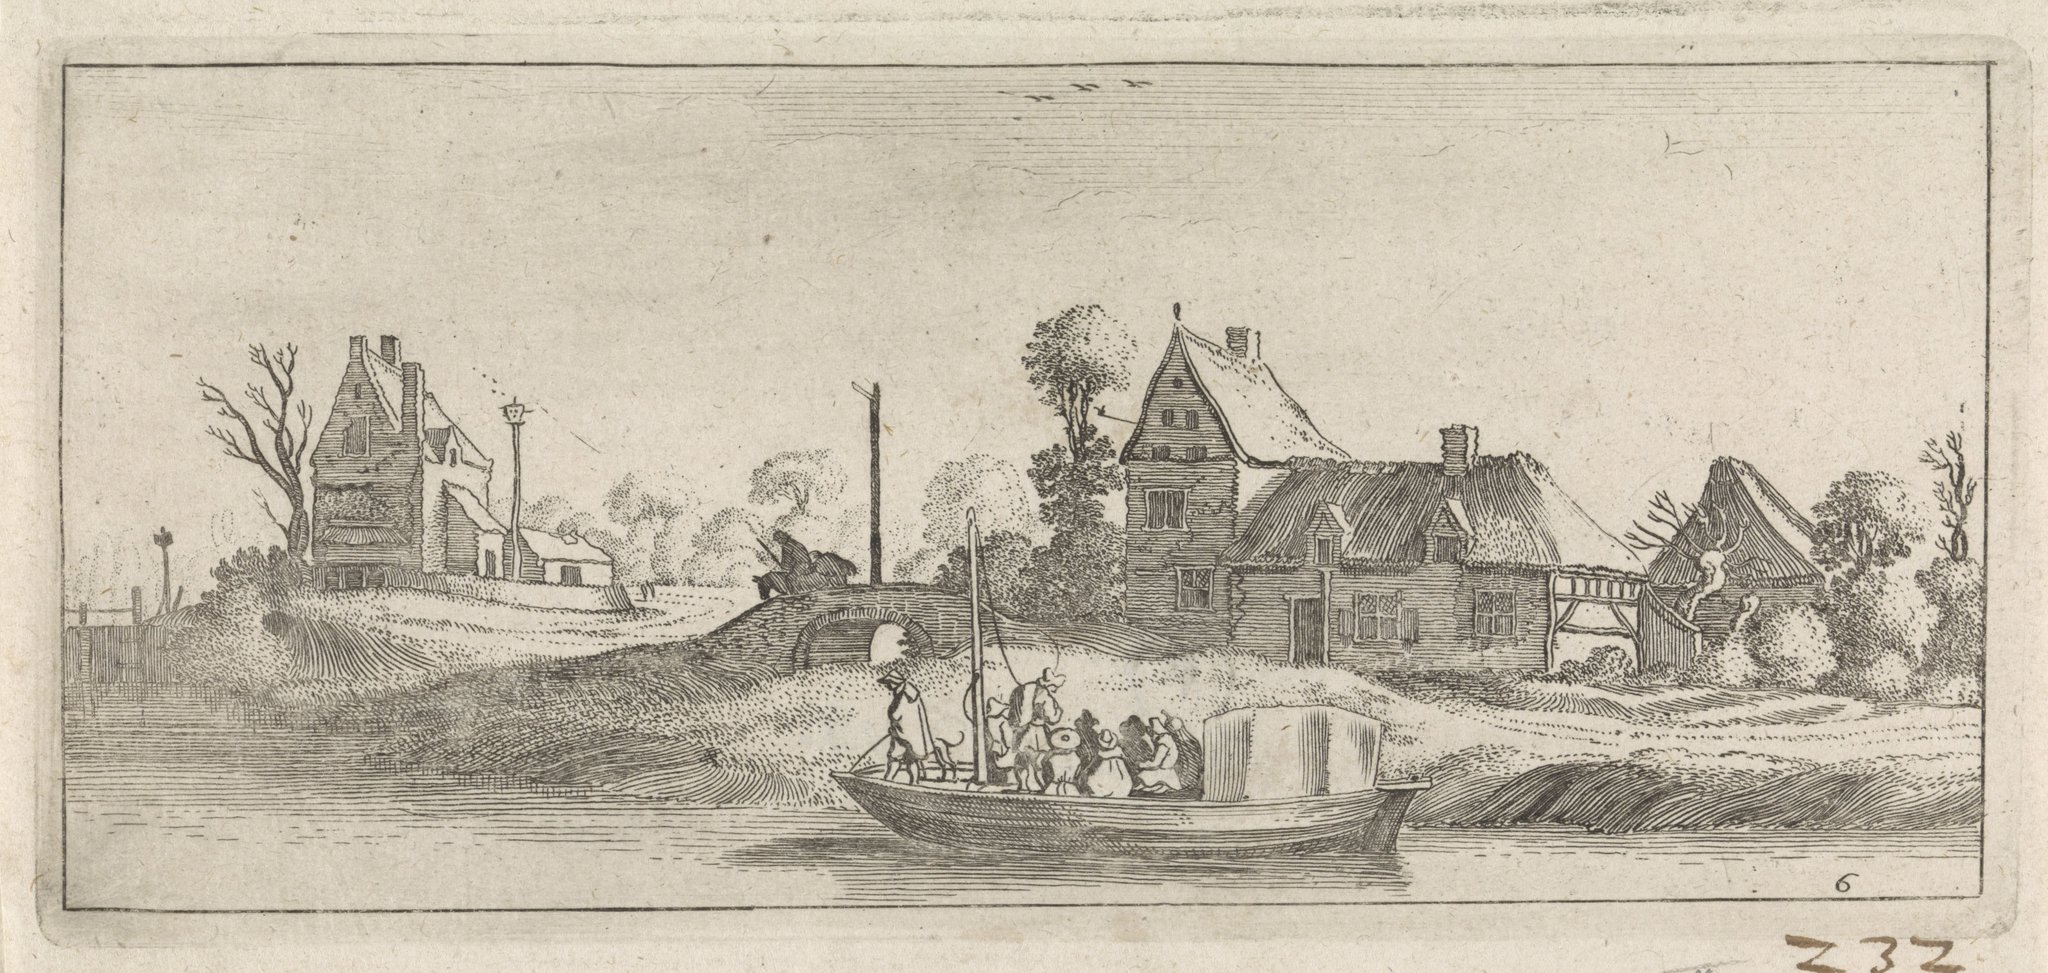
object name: print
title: Reizigers in een boot op een rivier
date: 1627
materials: paper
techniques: engraving, etching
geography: northern netherlands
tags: river, landscape with bridge, viaduct or aqueduct, boat propelled by man or animal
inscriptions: number: ‘232’, collector's mark: Lugt 964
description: Prent ook gebruikt als boekillustratie in: Campanus, M., Colevelt, J.J. Craen, A.P., Robbertzen, J. Amsterdamsche Pegasus, waer in (uyt lust) byeen vergadert zijn veel minnelycke liedekens. Amsterdam: Cornelis Willemsz Blaeu-laken, 1627.